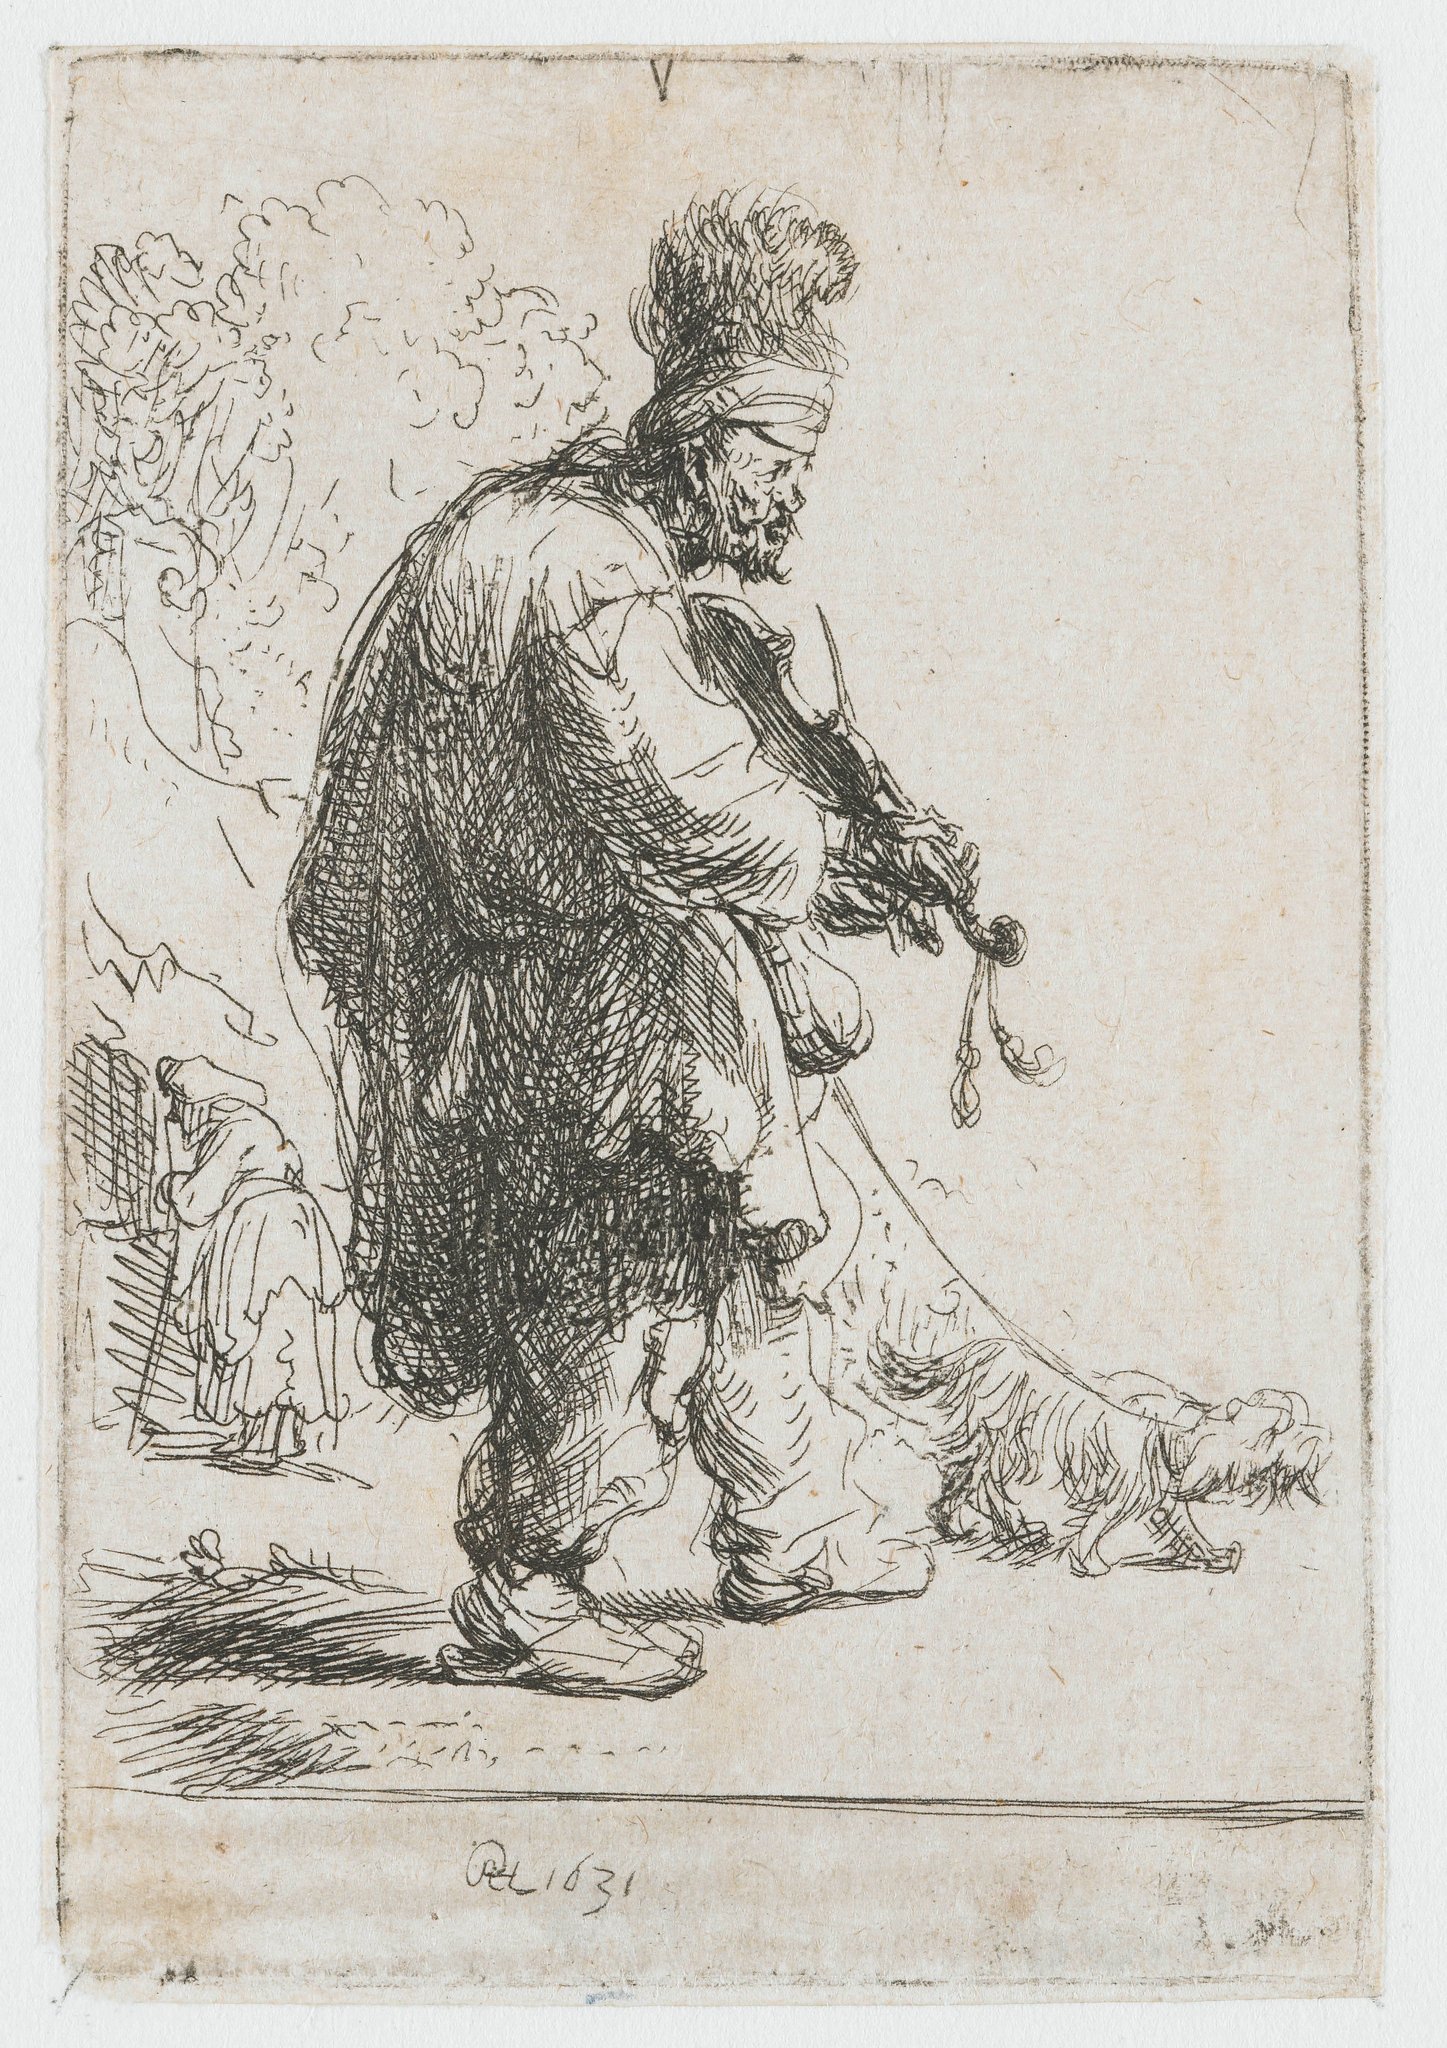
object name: print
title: The blind fiddler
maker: rembrandt van rijn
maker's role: draughtsman, painter, print maker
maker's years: 1606-1669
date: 1631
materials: paper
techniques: etching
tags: violin, fiddle, blind, blindness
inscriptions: monogram and date: ‘RHL 1631’, collector's mark: Lugt 240